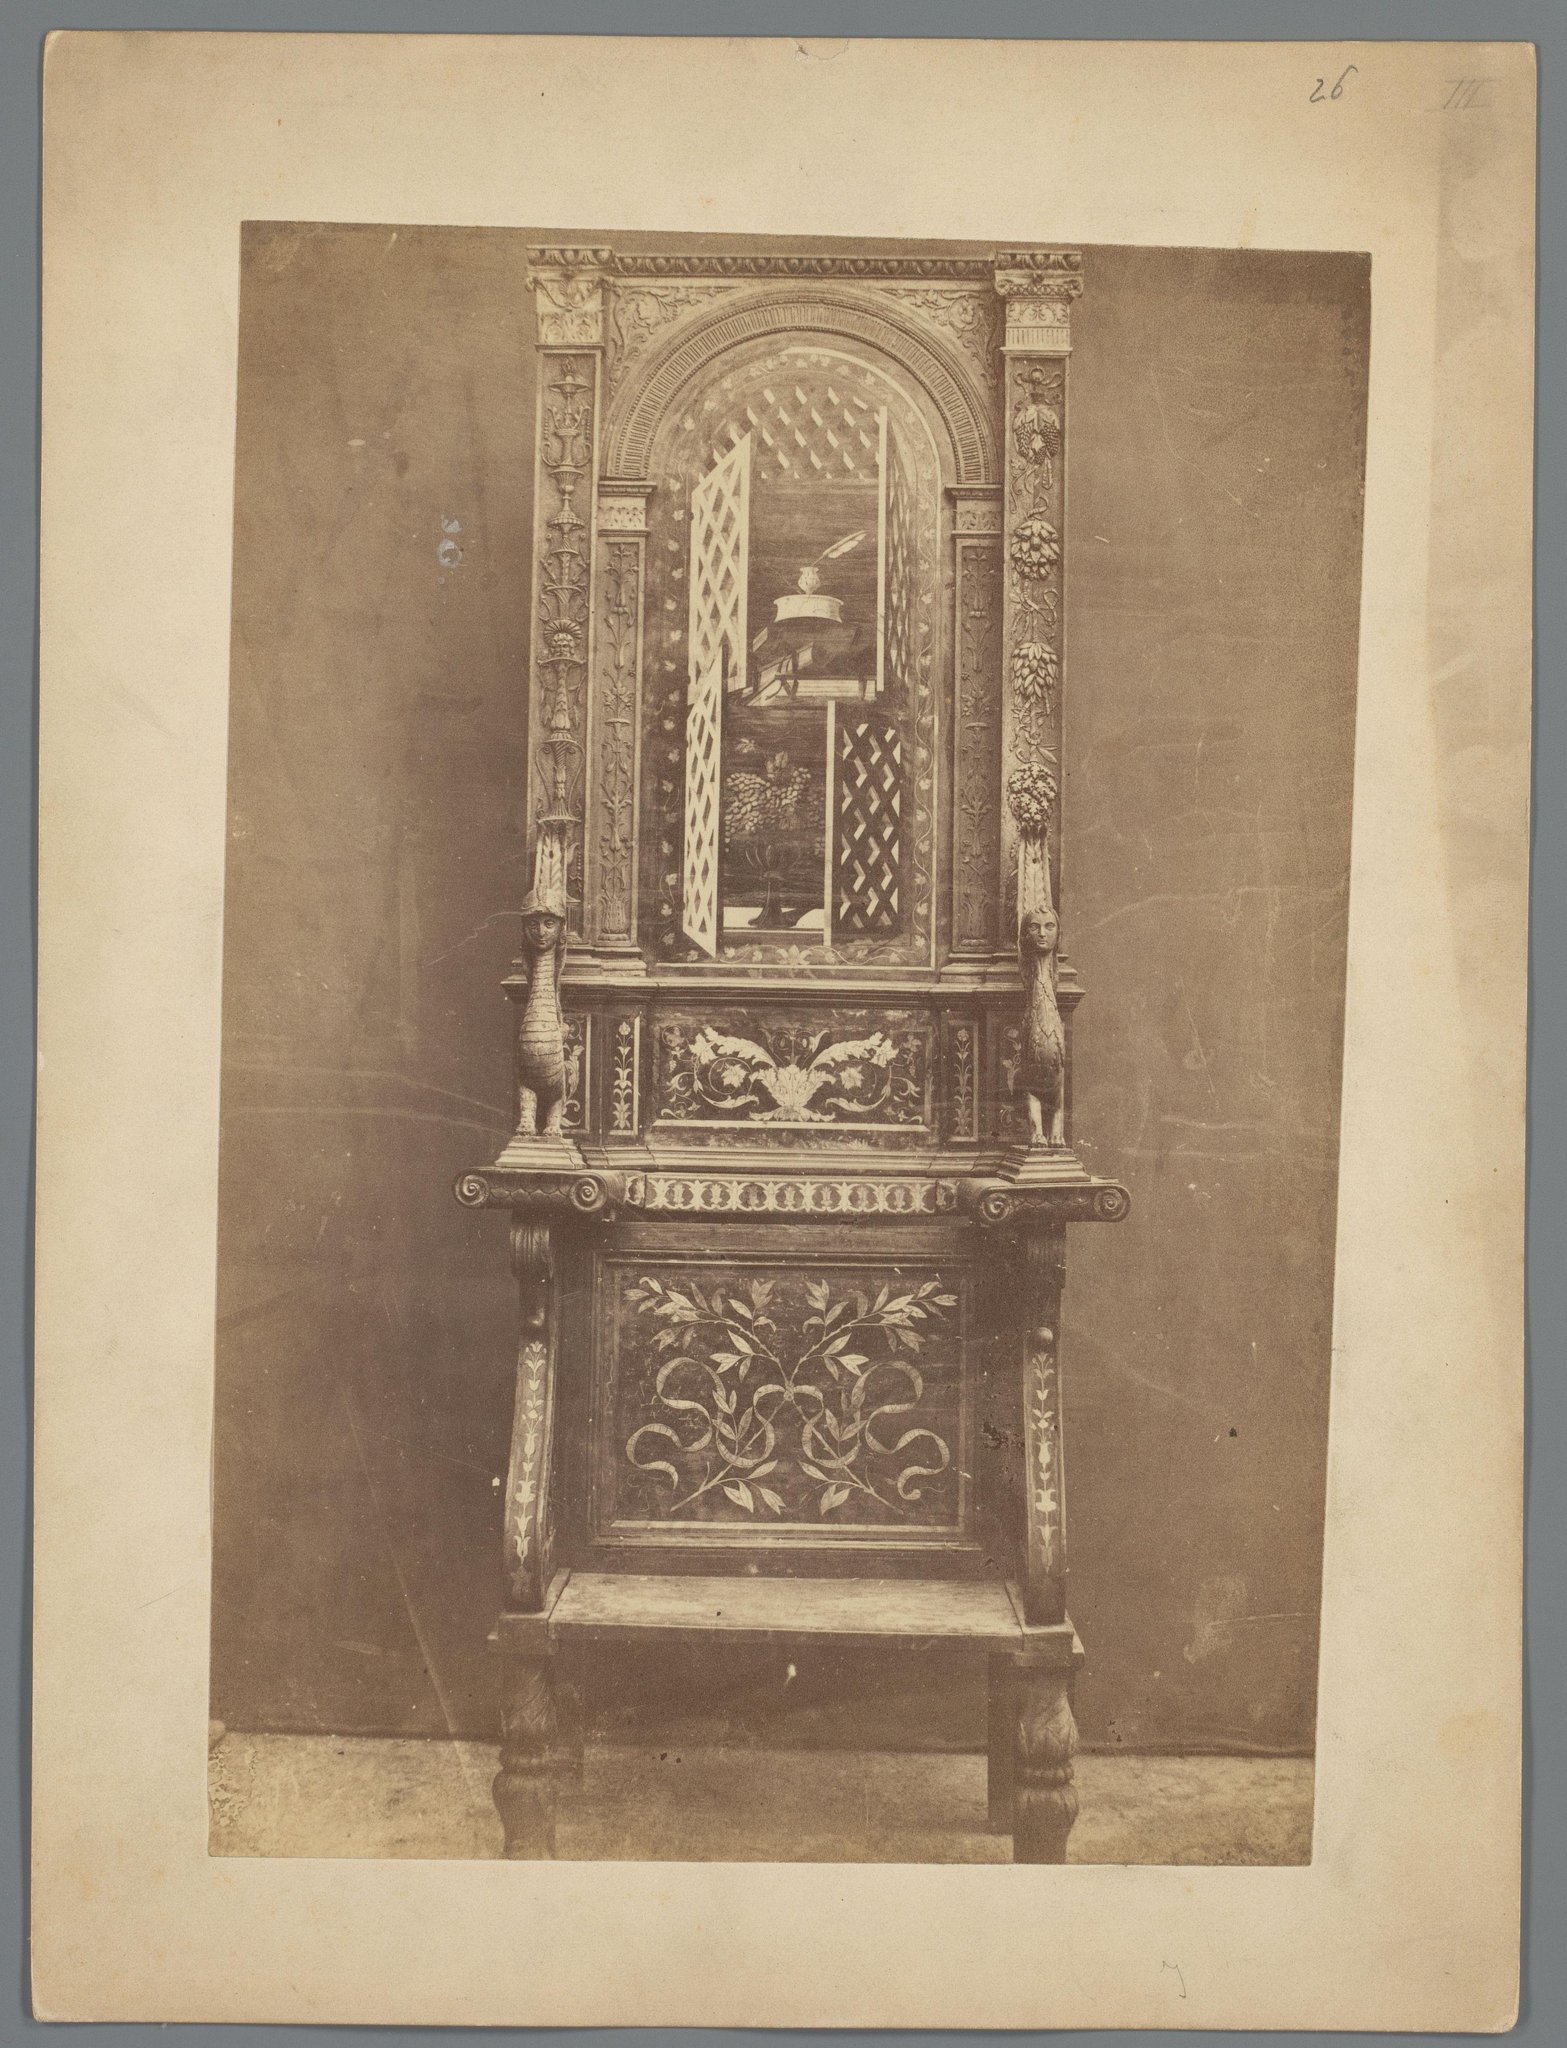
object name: photograph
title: Kabinetkast met trompe-l'oeil-effect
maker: Anonymous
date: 1880-1910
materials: cardboard, paper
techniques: albumen print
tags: ornamental cupboard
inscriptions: collector's mark: Lugt 3937